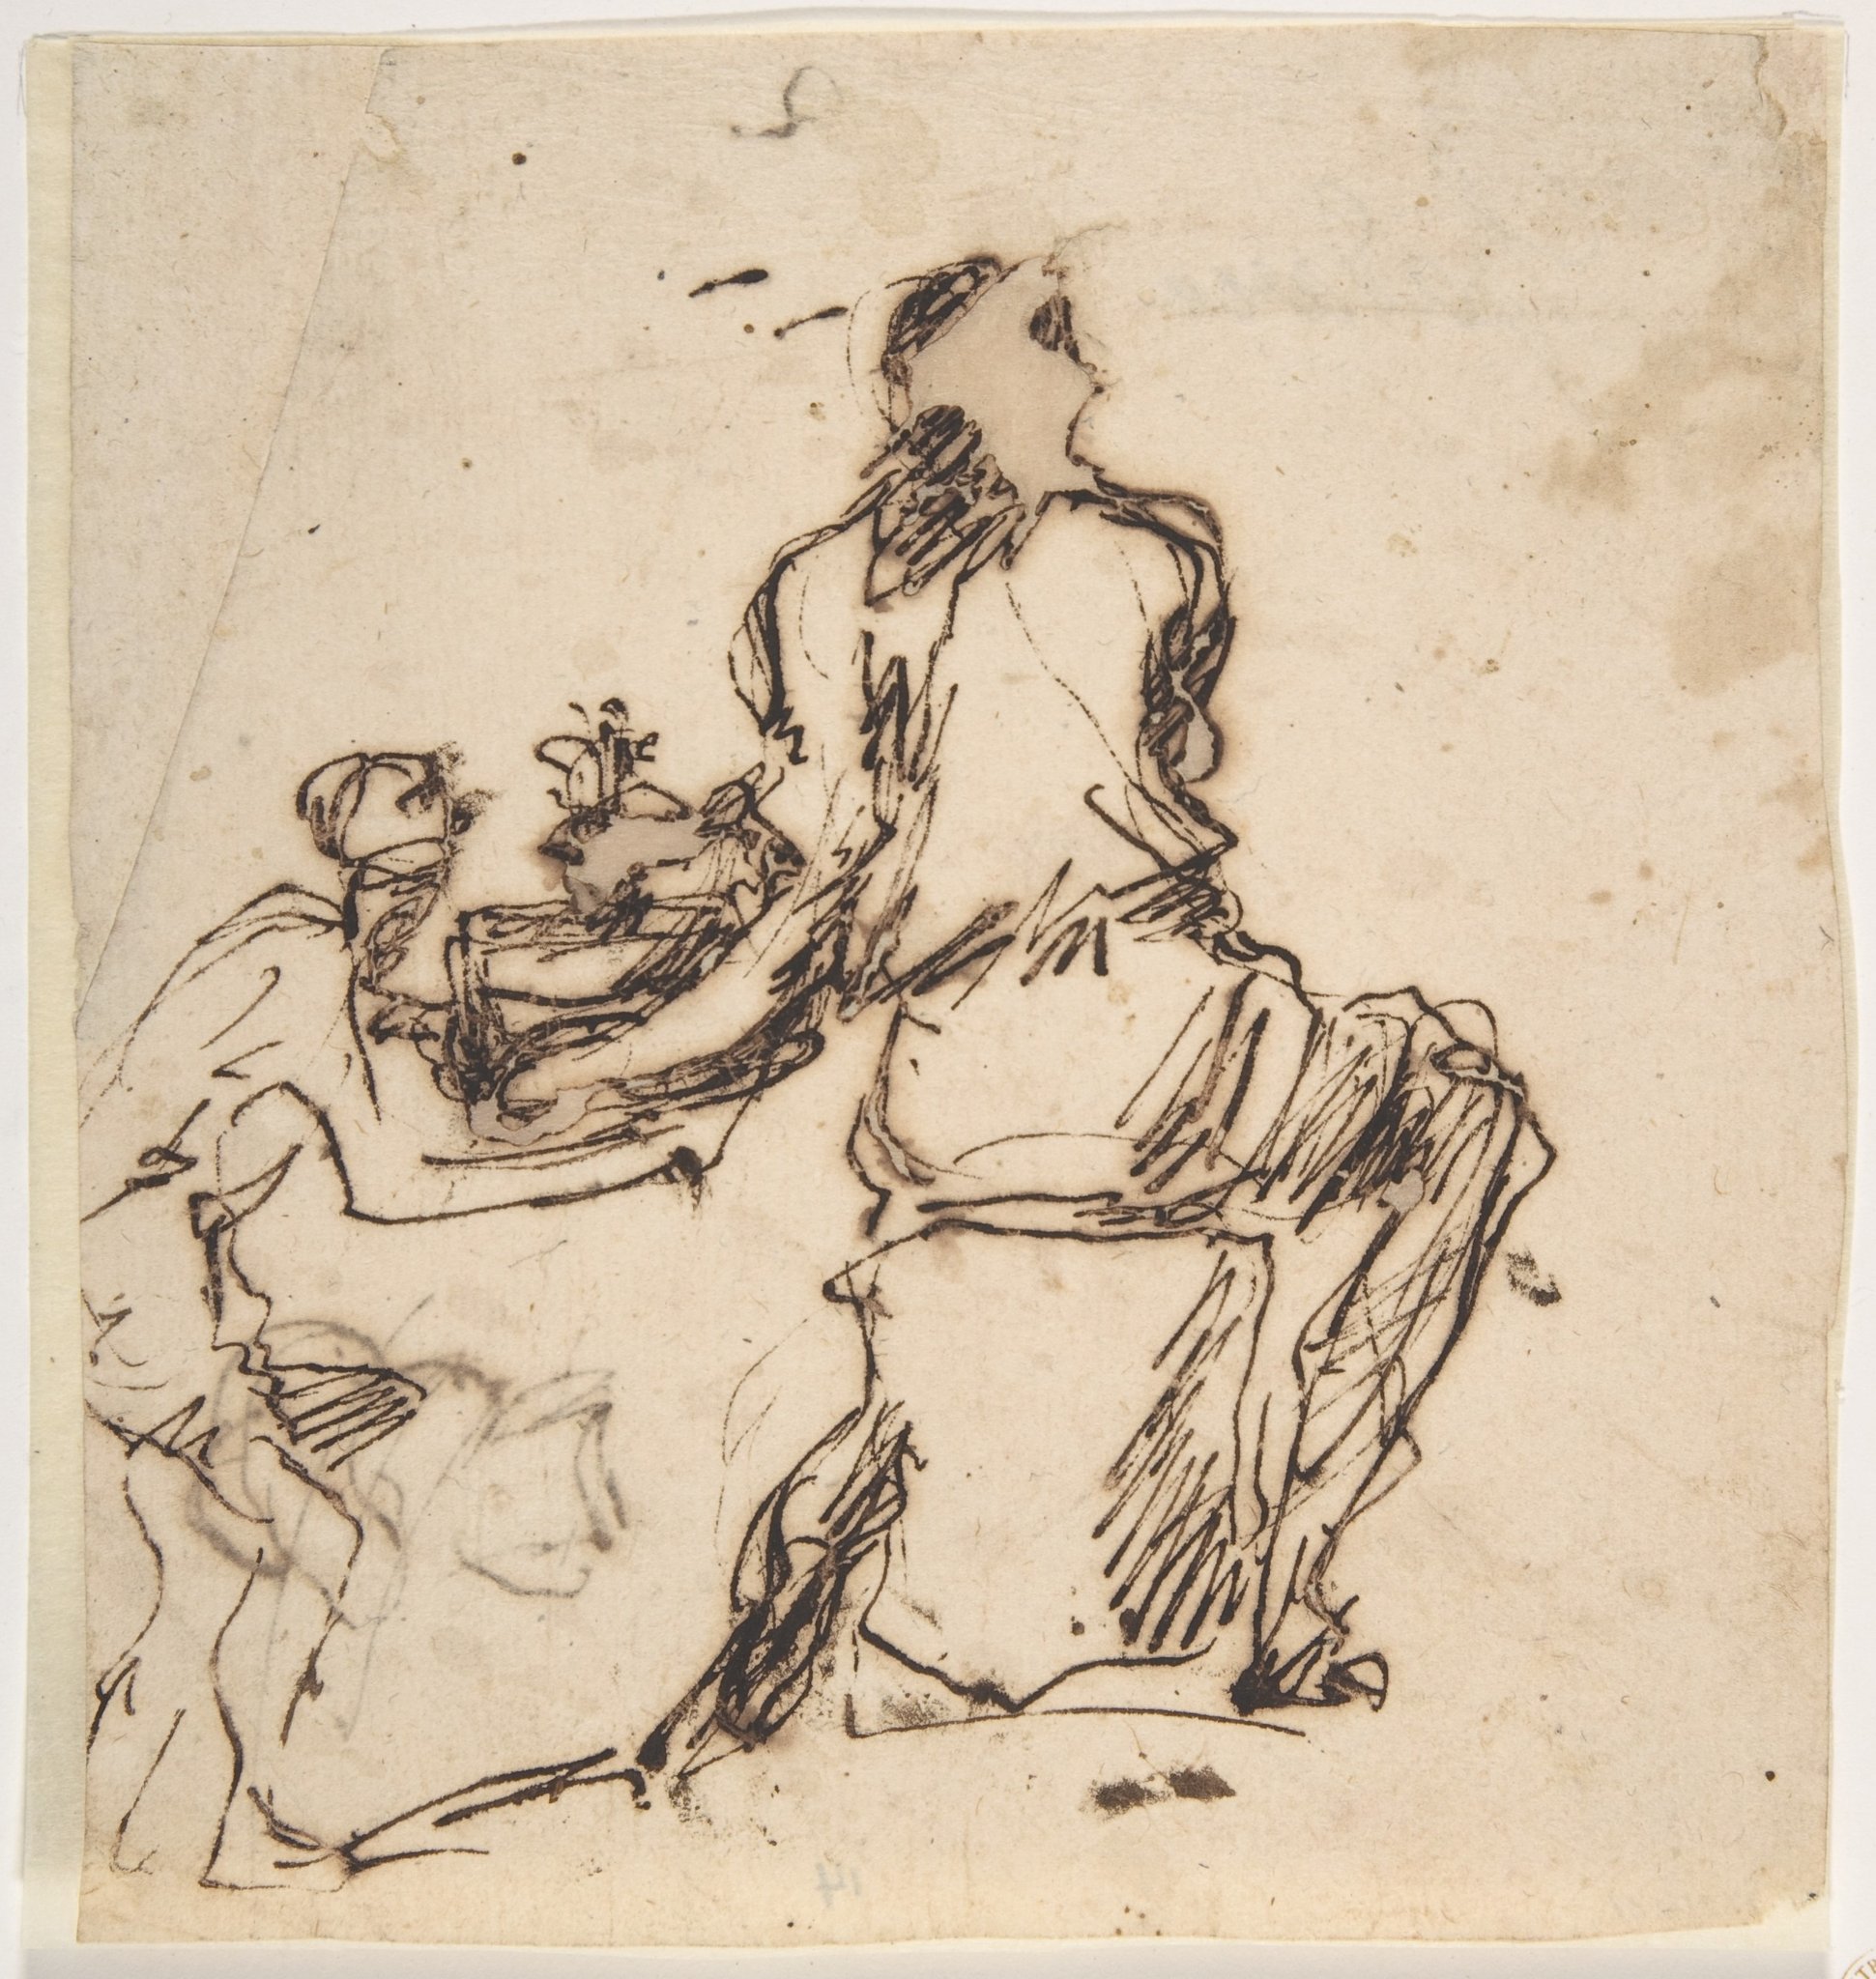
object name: drawing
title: Seated Figure Receiving an Object Presented by a Smaller Figure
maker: micco spadaro (domenico gargiulo)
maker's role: artist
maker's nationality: italian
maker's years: 1609-1675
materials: ink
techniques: pen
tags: human figures